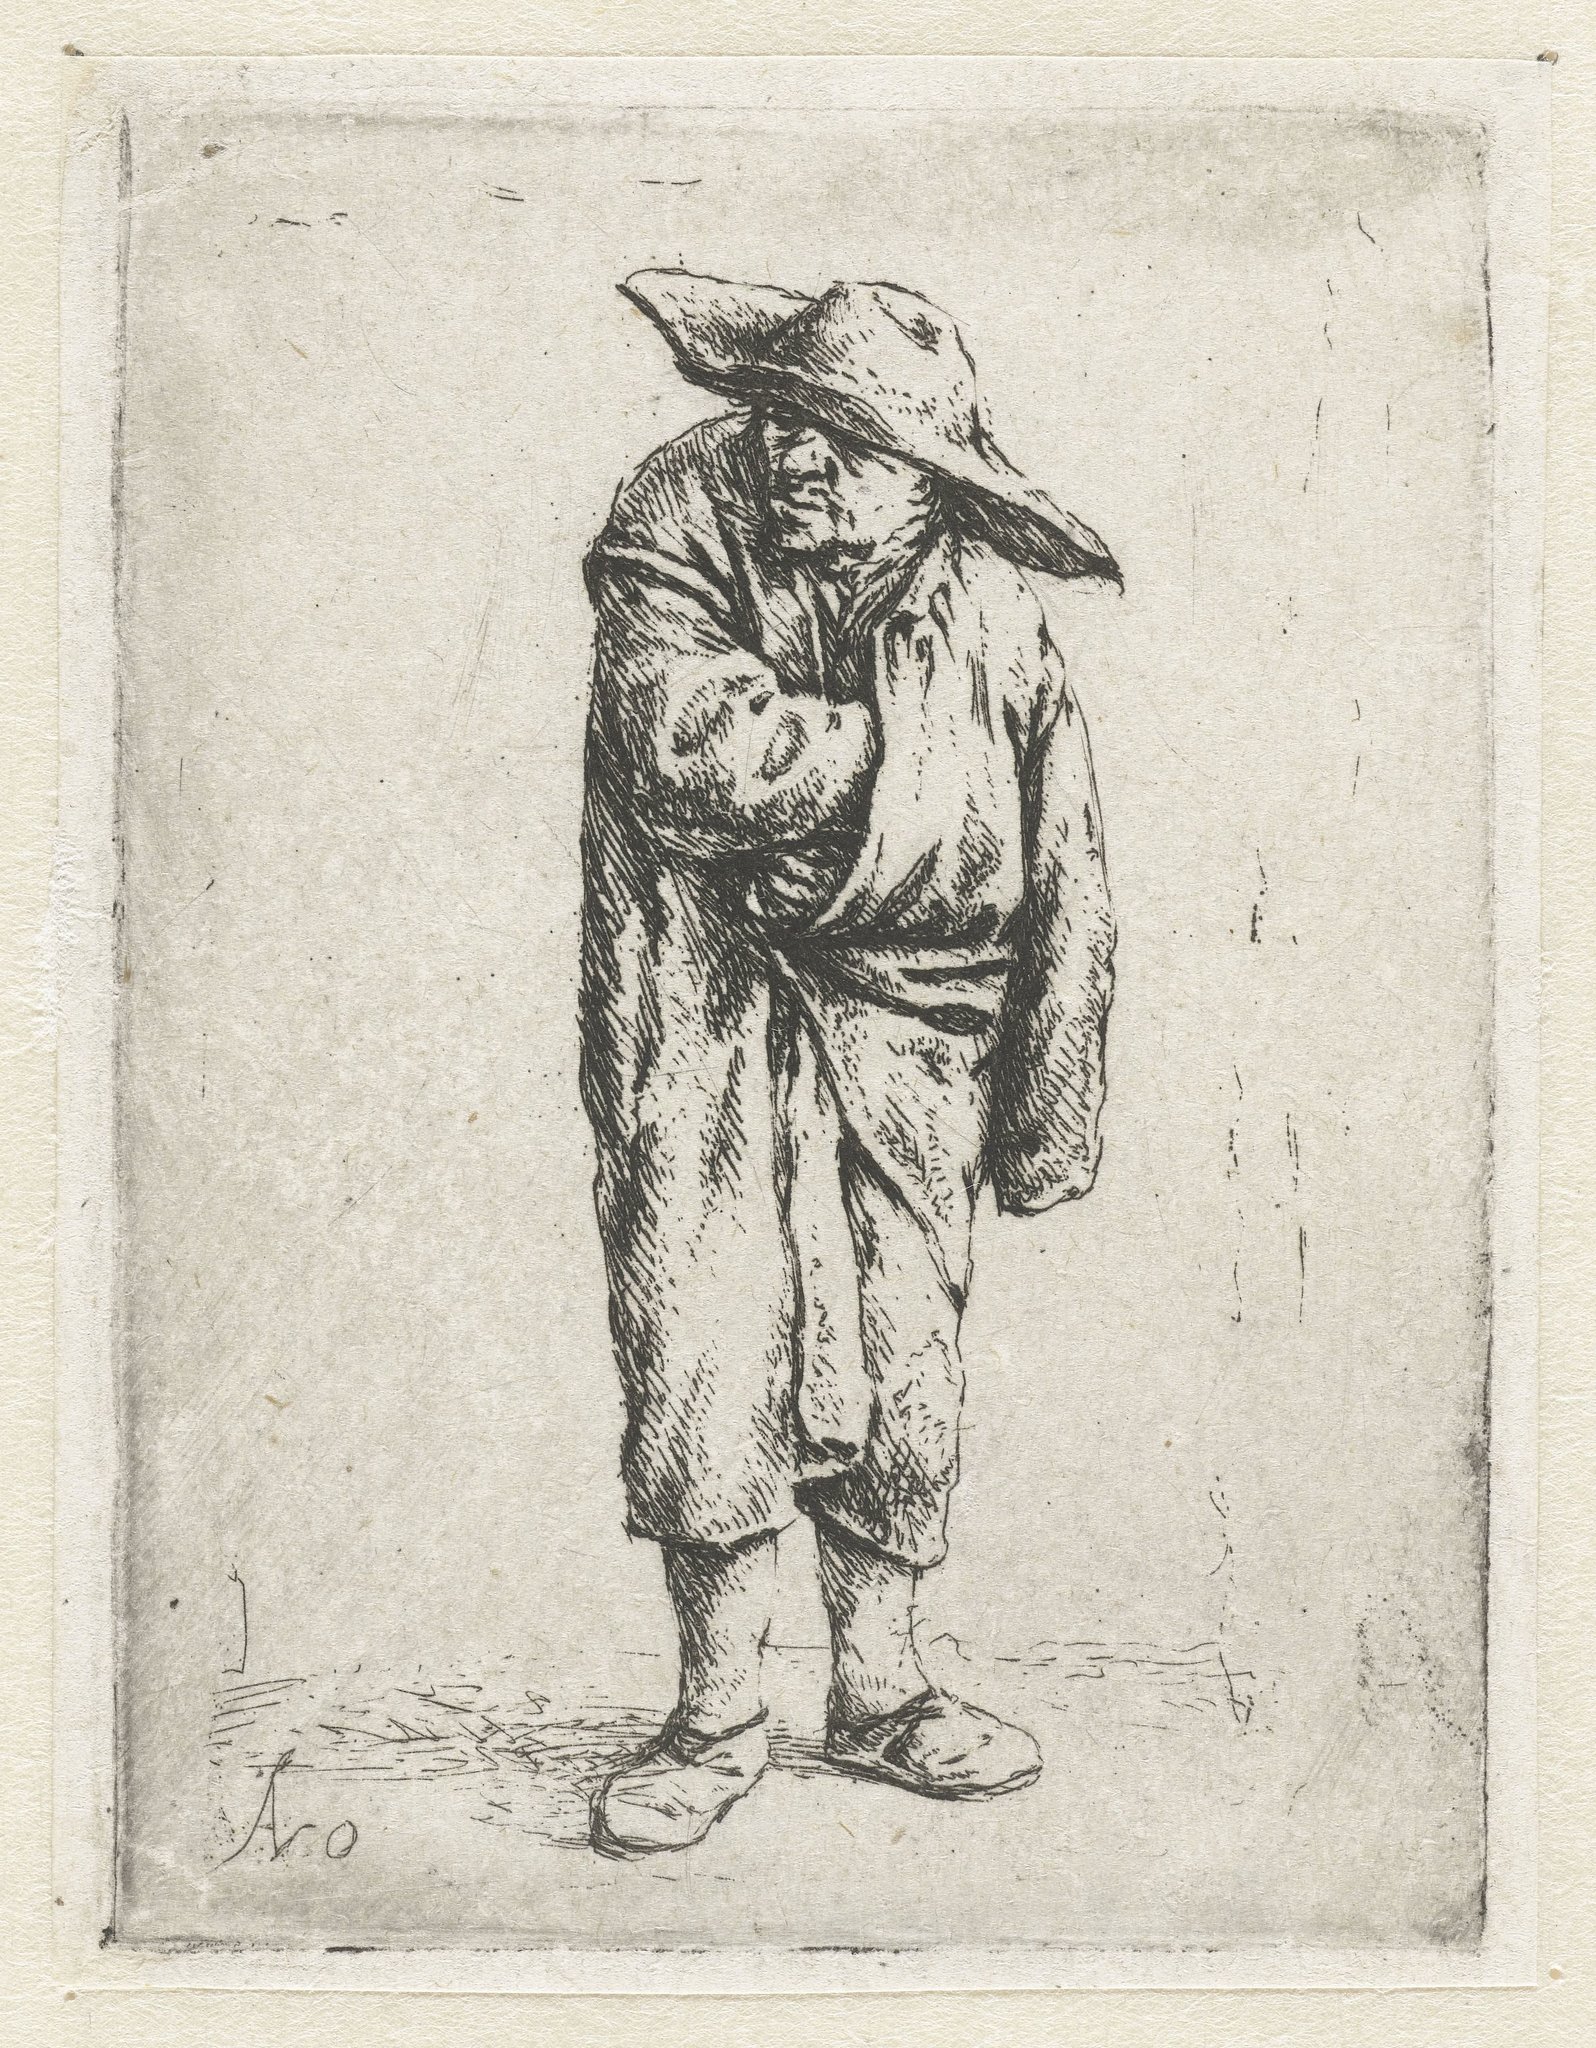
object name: print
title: Staande boer met hand en arm in zijn mantel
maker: adriaen van ostade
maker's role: draughtsman, painter, print maker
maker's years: 1610-1685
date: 1646-1648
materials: paper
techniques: etching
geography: haarlem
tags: coat (+ men's clothes), male sex; man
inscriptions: collector's mark: Lugt 240